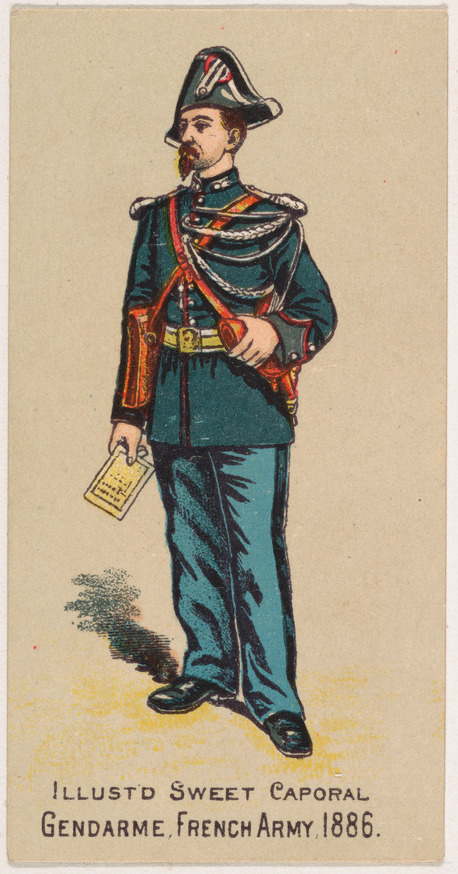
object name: print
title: Gendarme, French Army, 1886, from the Military Series (N224) issued by Kinney Tobacco Company to promote Sweet Caporal Cigarettes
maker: kinney brothers tobacco company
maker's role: publisher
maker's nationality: american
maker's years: 1869-2011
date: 1888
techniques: color lithograph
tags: soldiers,men